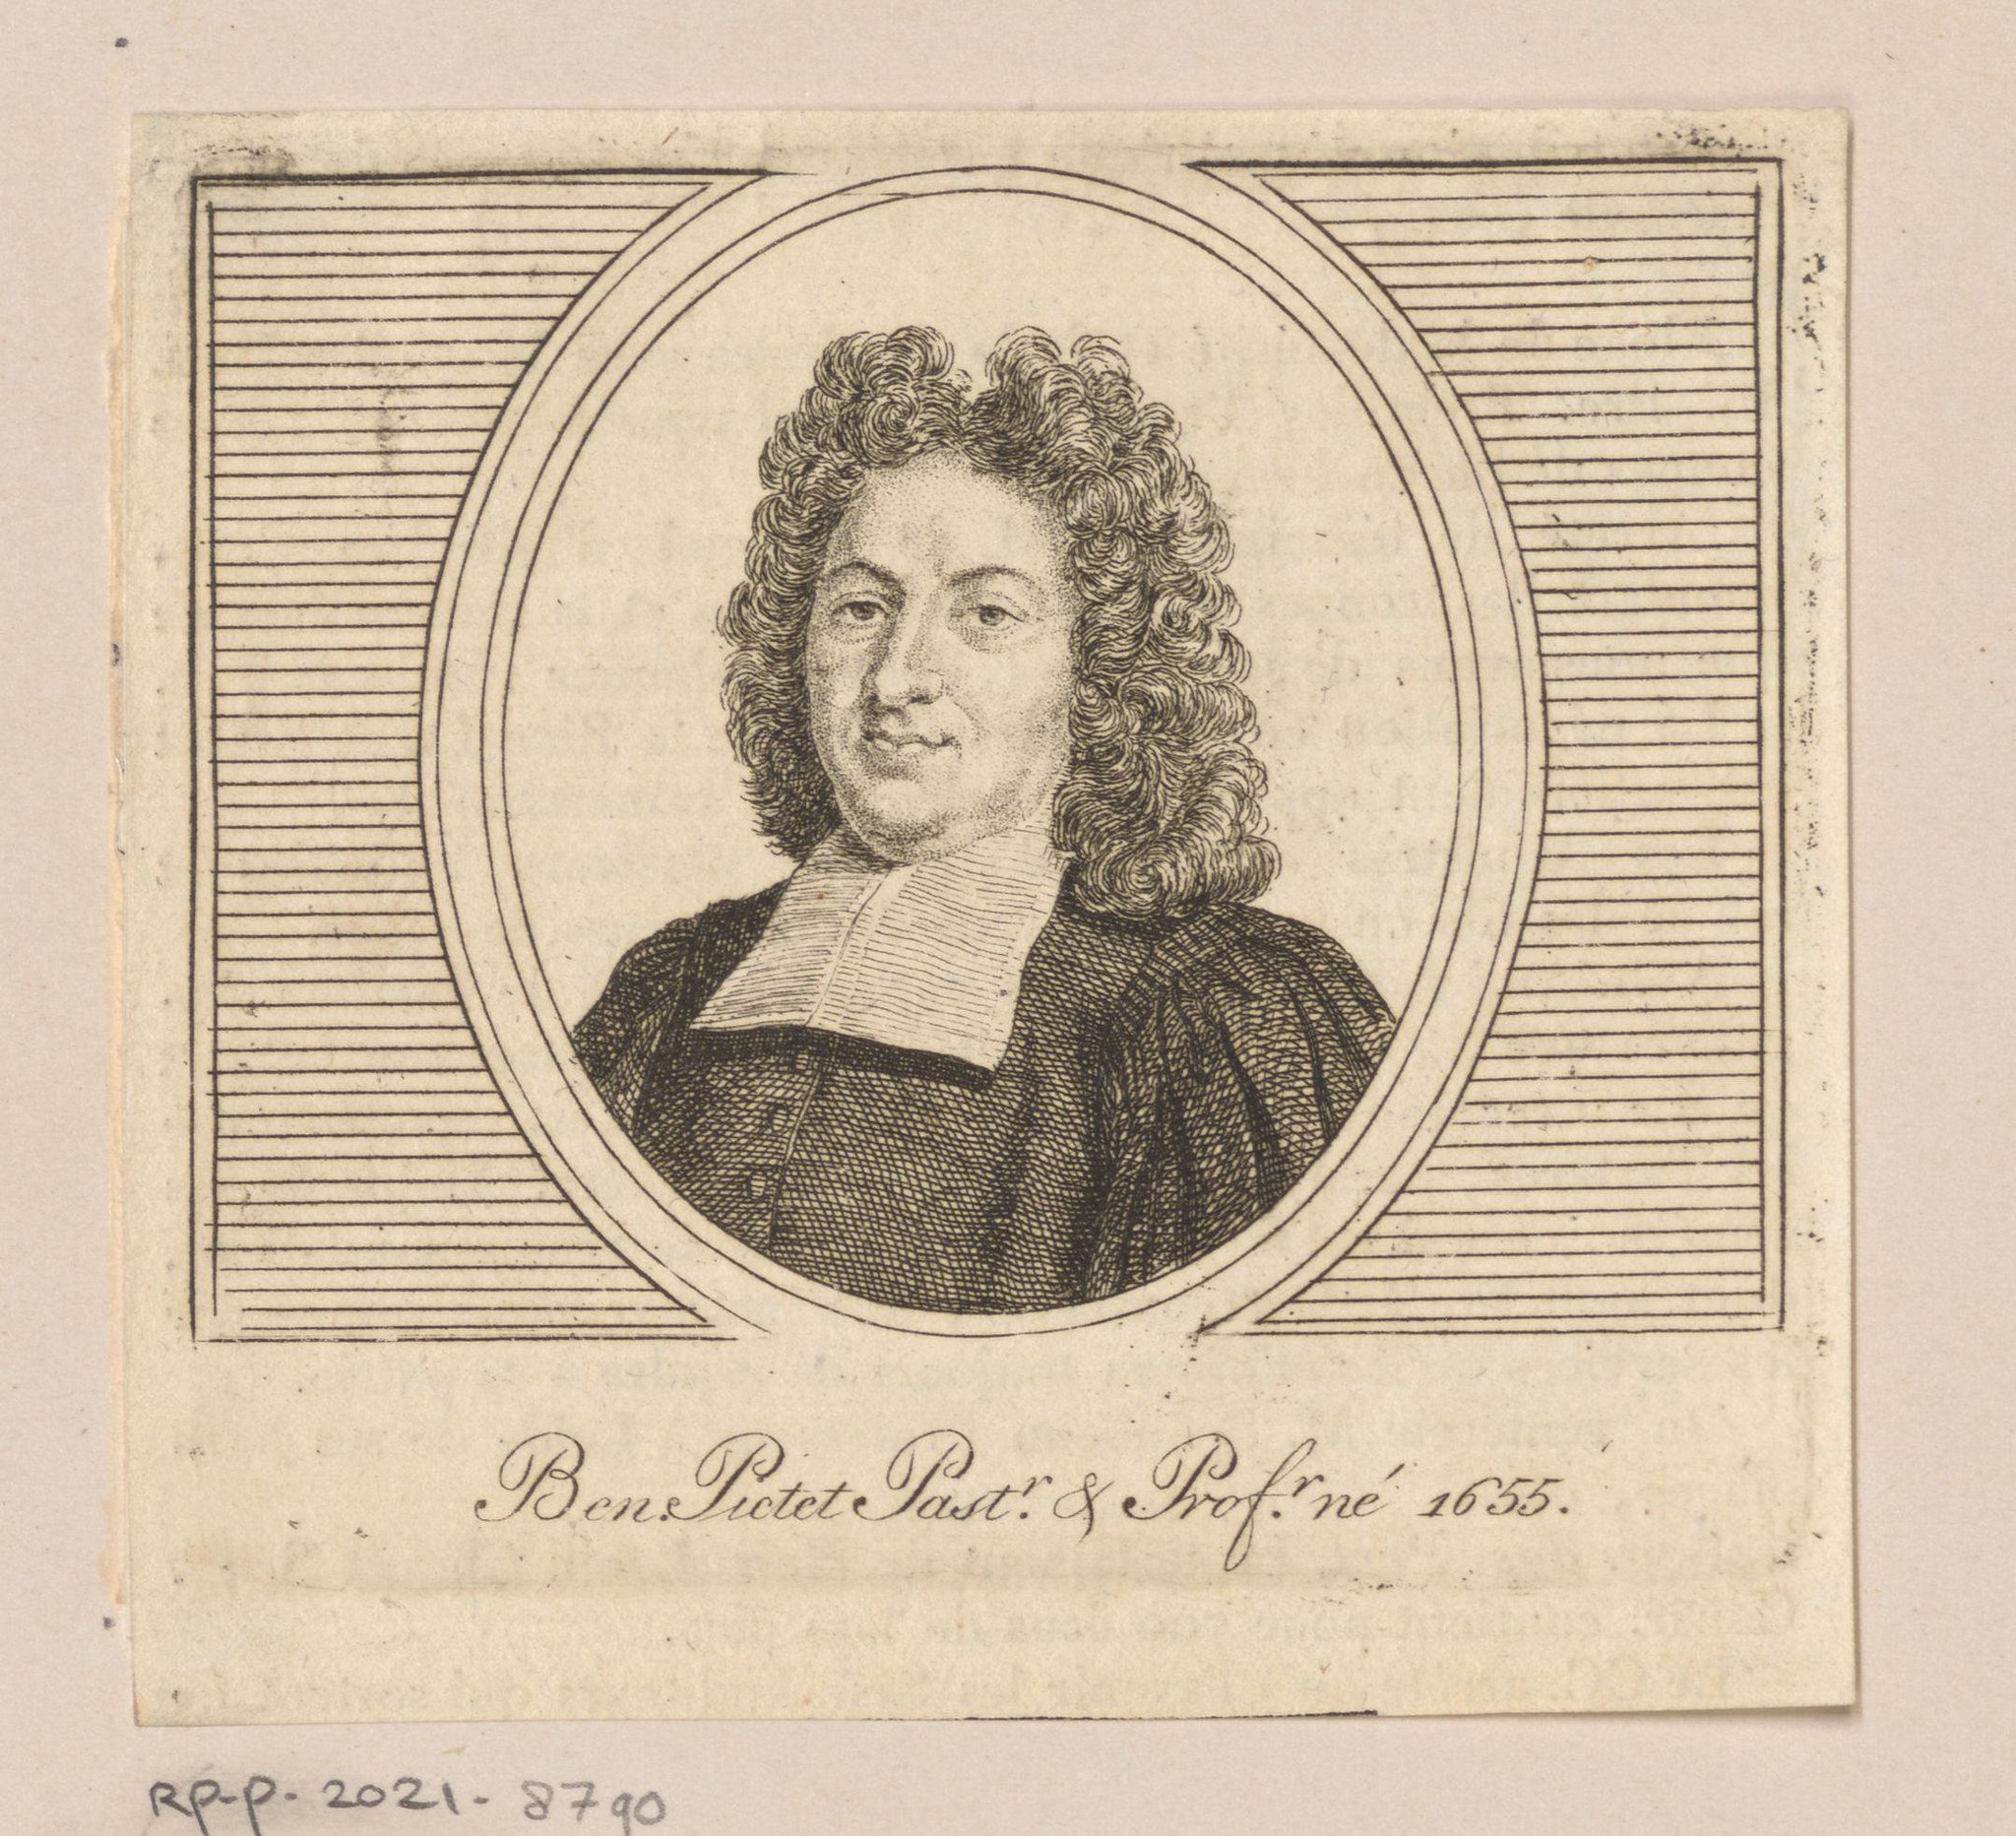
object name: print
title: Portret van Benedict Pictet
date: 1815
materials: paper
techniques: engraving, etching, letterpress printing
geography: geneva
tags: benedict pictet, adult man, historical persons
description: Prent uit: Grenus, Théodore de. Fragmens biographiques et historiques: extraits des registres du Conseil d'Etat de la République de Genève, dès 1535 à 1792. Genève: Manget et Cherbuliez, 1815.